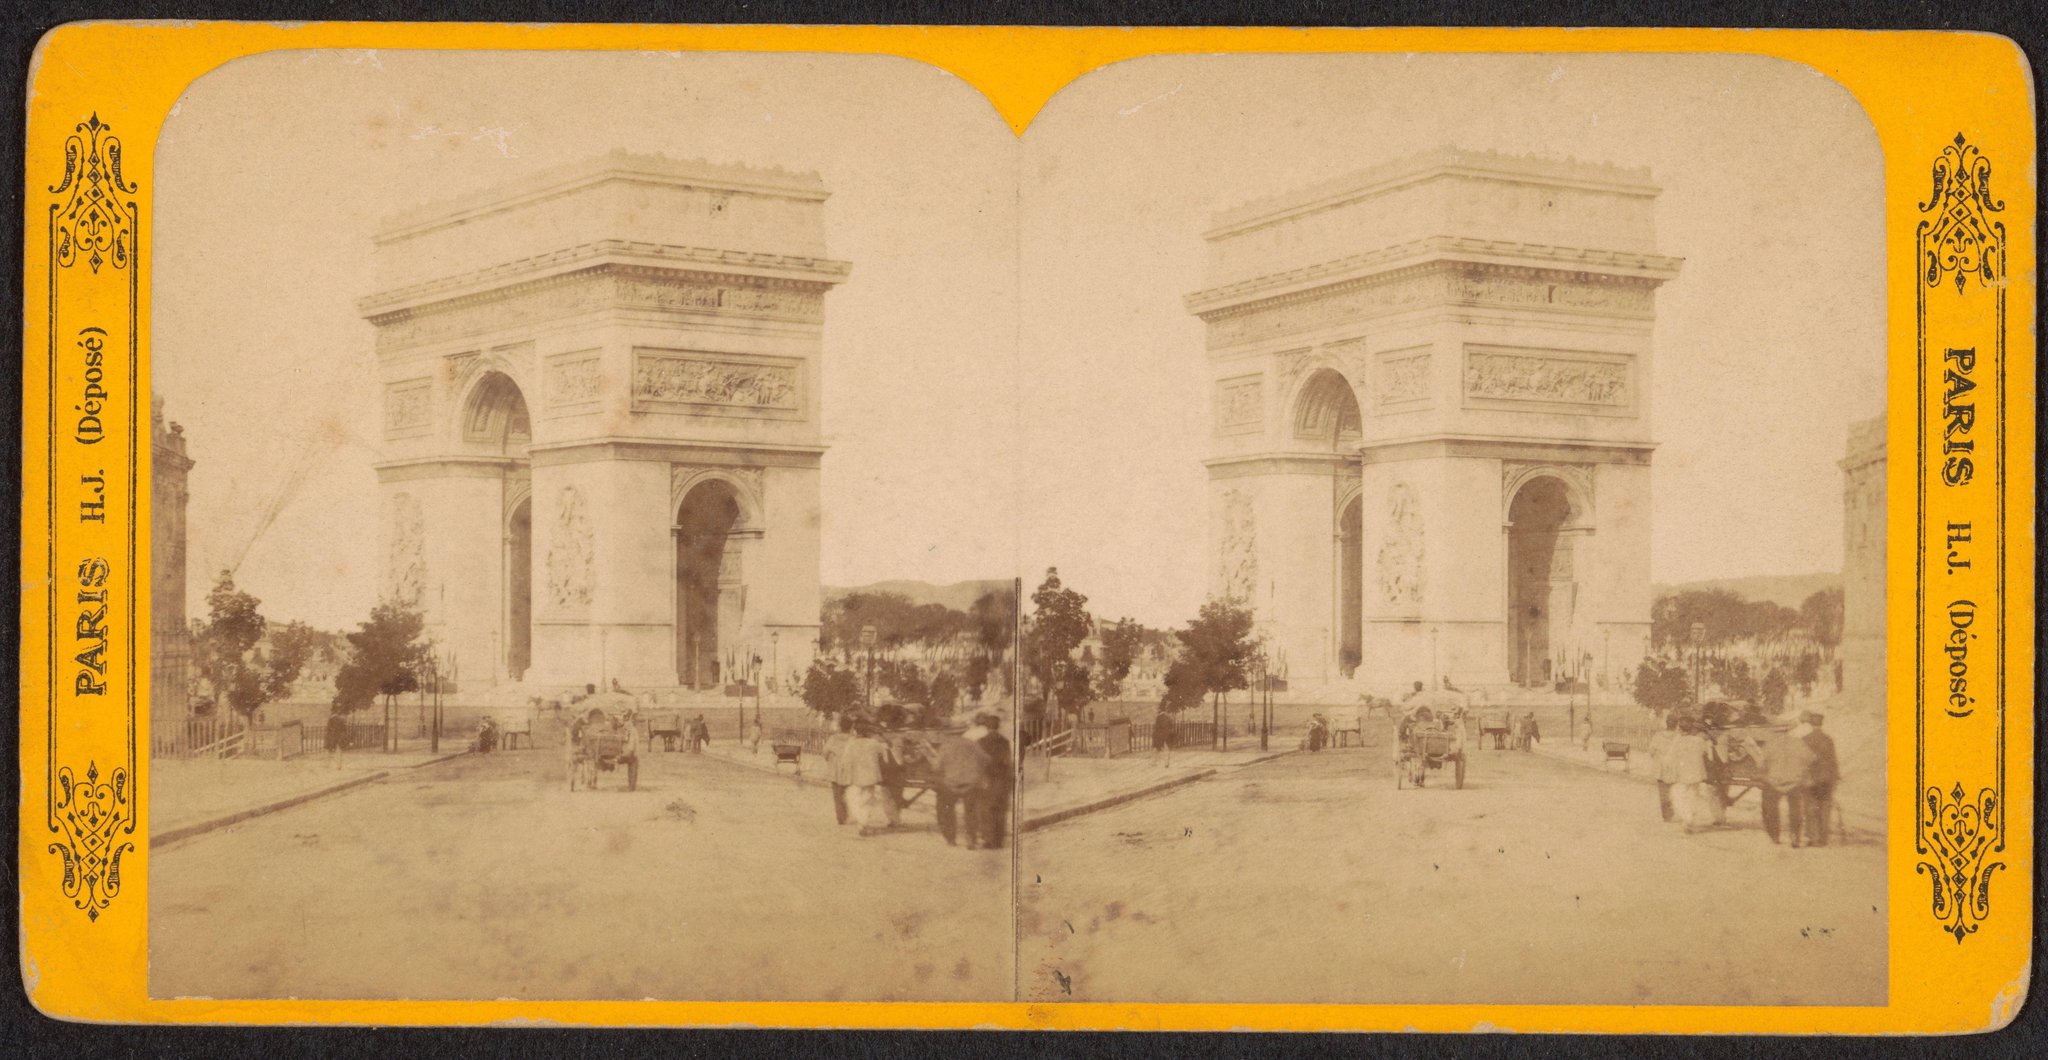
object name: stereograph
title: Arc de triomphe de l'Étoile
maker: hippolyte jouvin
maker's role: fotograaf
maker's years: 1825-1889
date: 1850-1880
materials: cardboard, photographic support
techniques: albumen print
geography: paris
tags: triumphal arch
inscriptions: number: ‘N. 65’